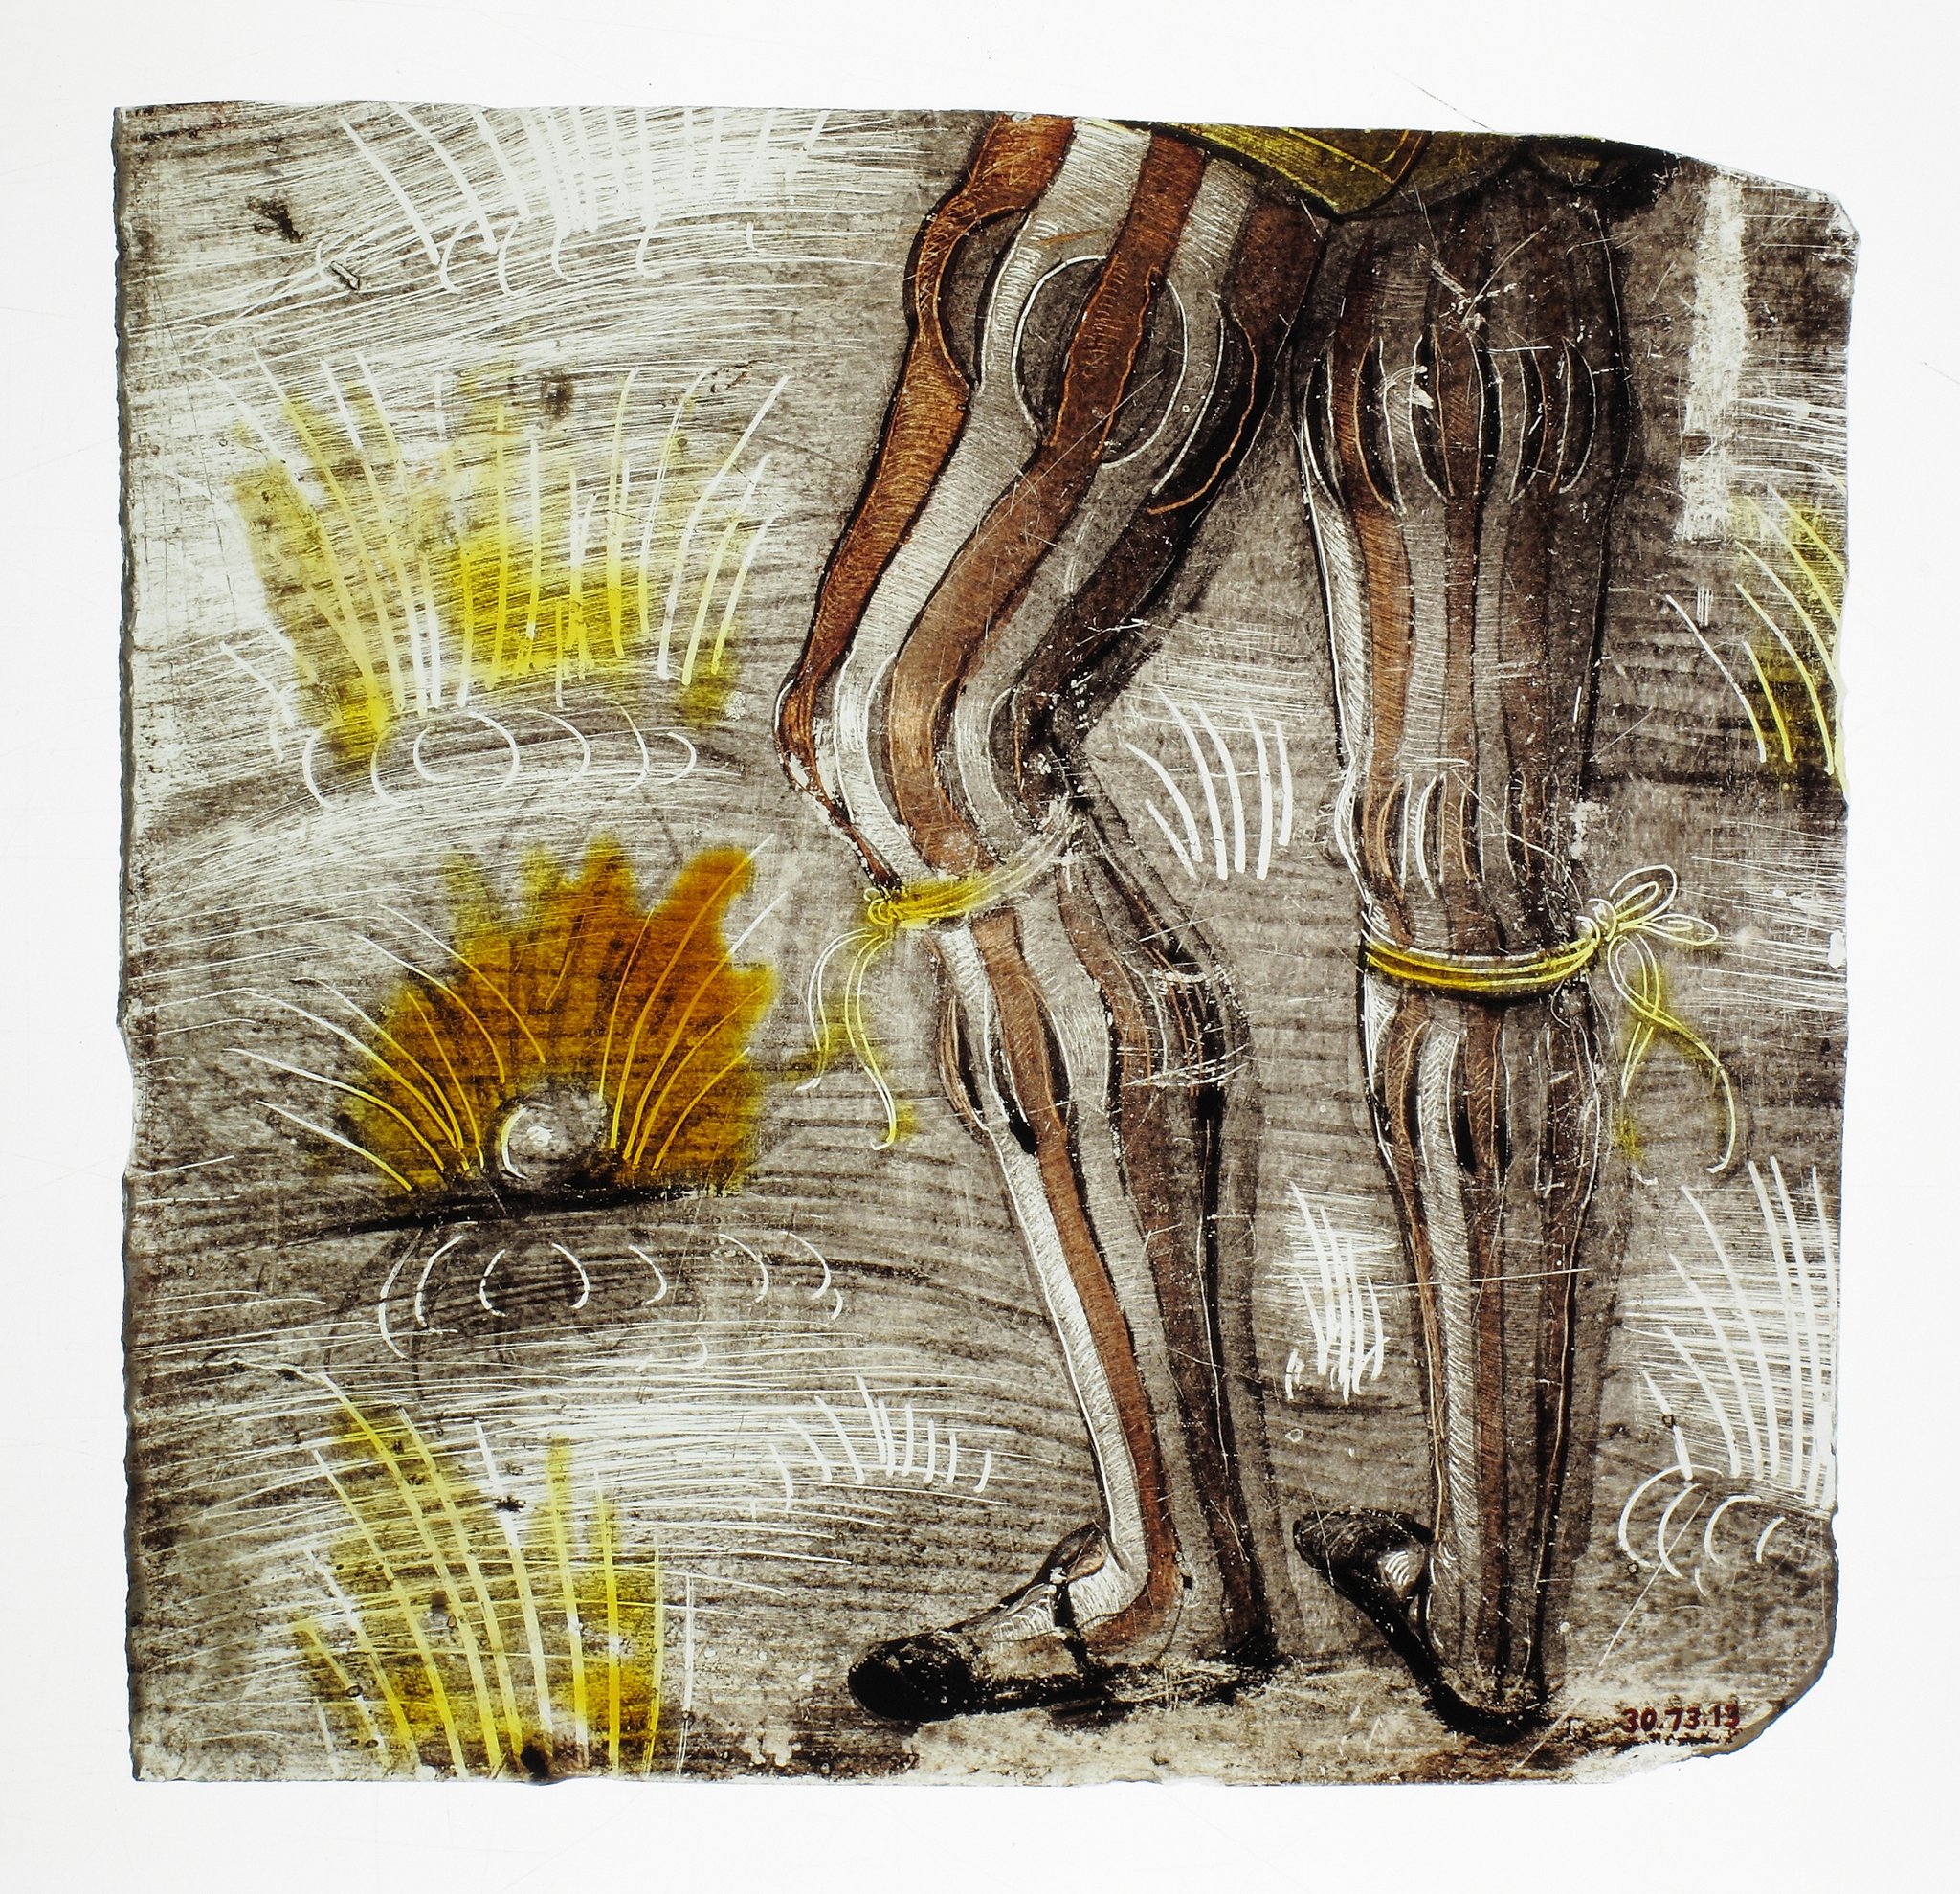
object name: fragment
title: Glass Fragment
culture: south netherlandish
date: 1501-1600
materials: glass